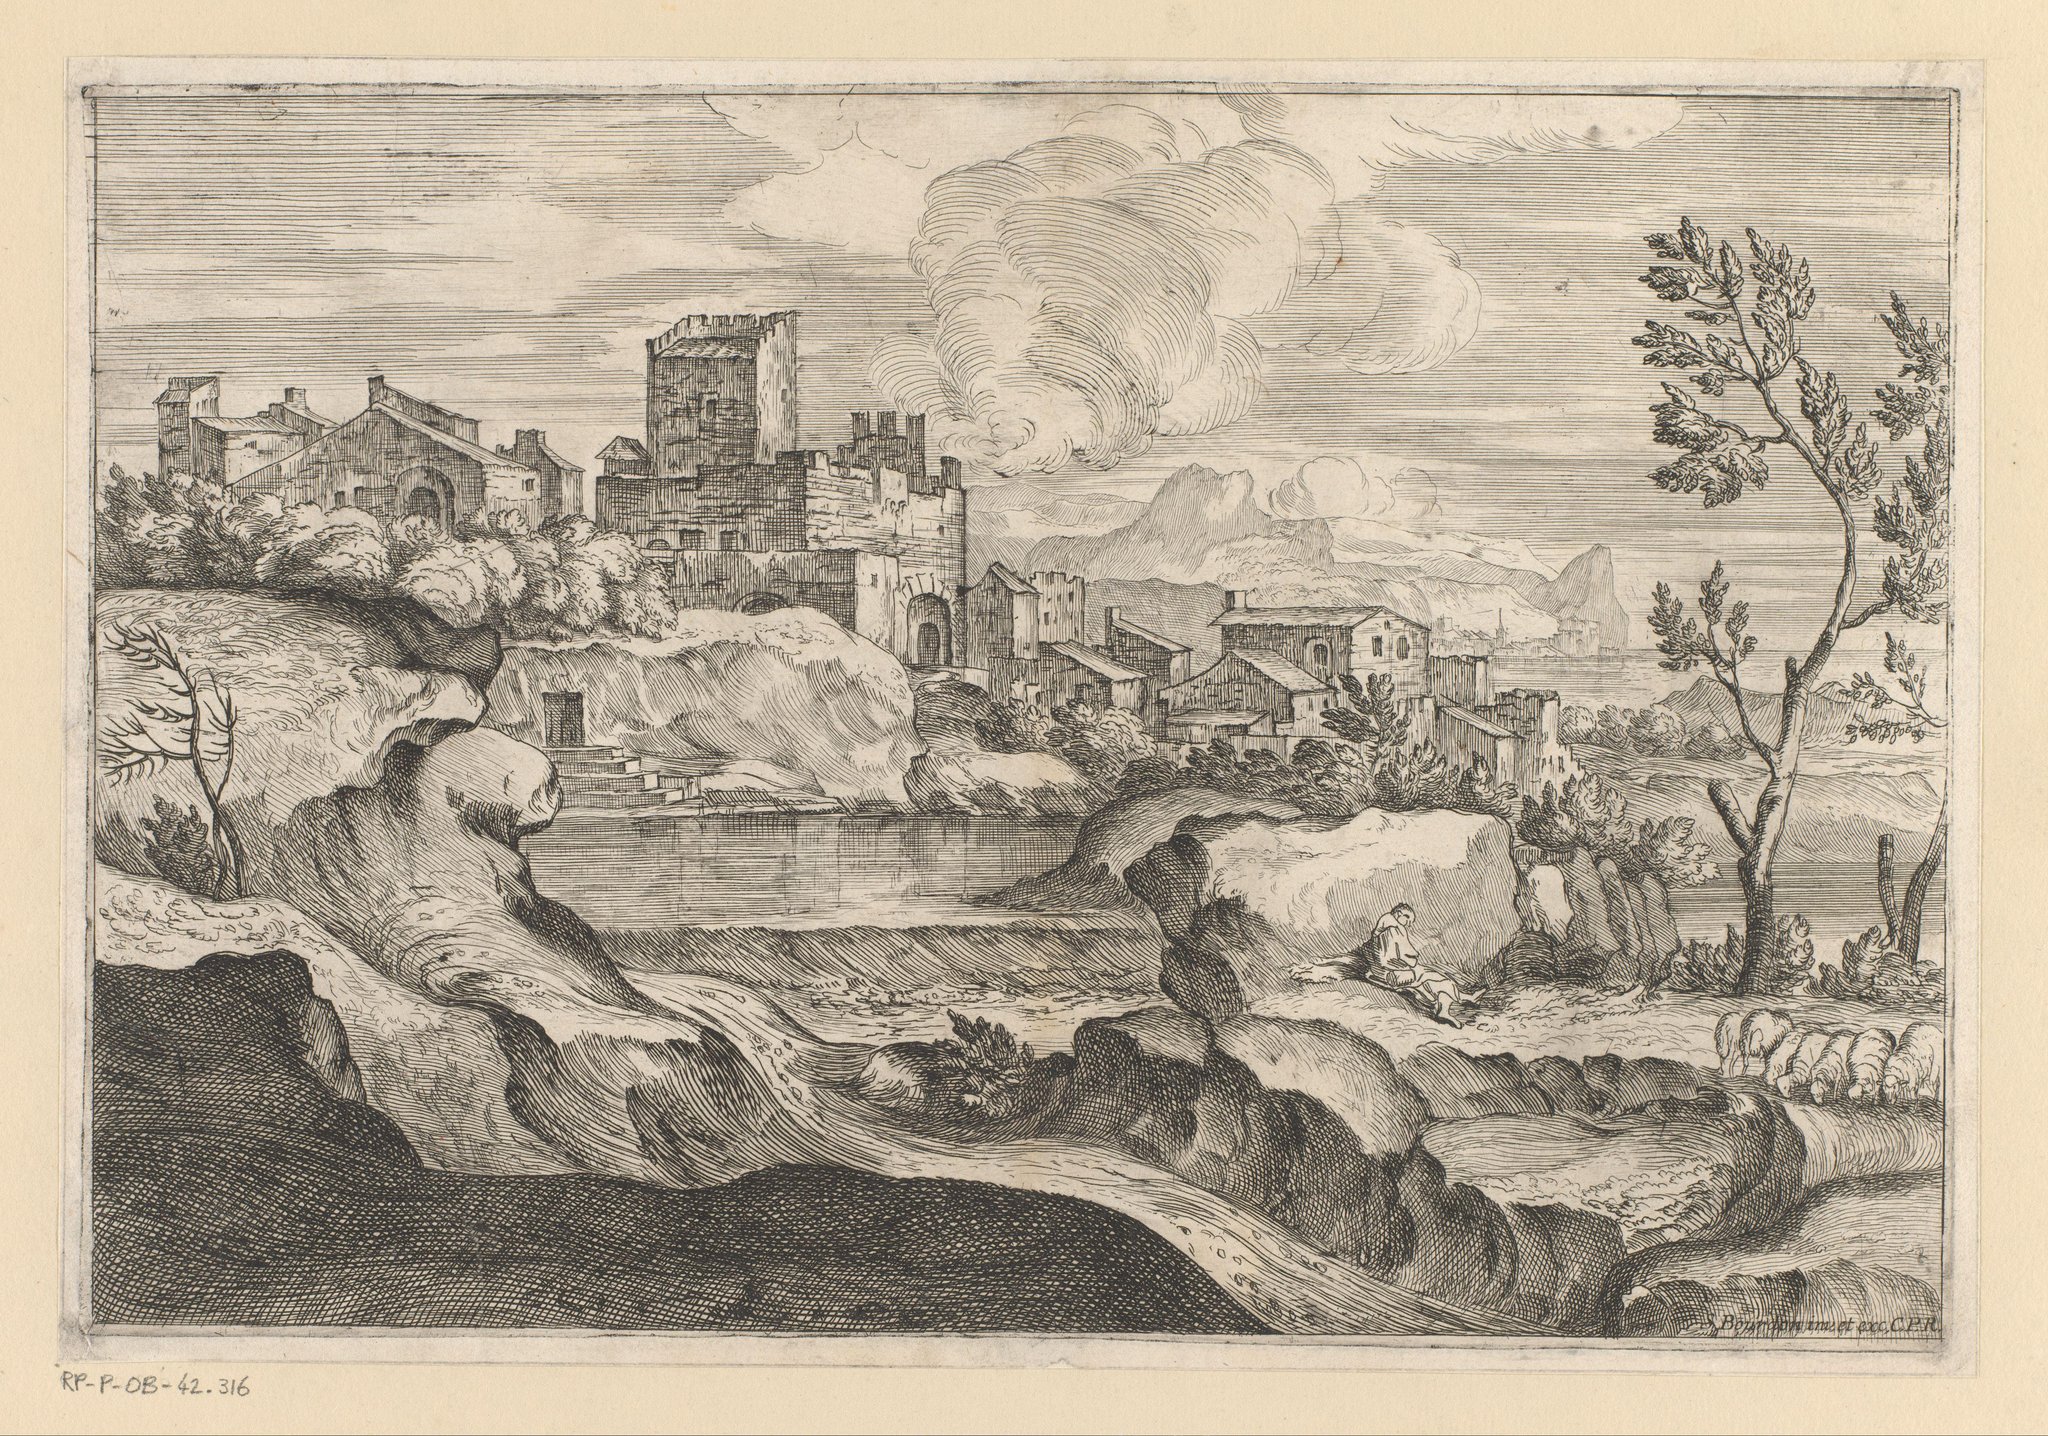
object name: print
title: Landschap met een herder met kudde voor een stad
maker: sébastien bourdon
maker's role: draughtsman, painter, print maker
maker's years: 1616-1671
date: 1626-1671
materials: paper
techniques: etching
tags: landscapes, city-view in general; 'veduta', herding, herdsman, herdswoman, shepherd, shepherdess, cowherd, etc.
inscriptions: collector's mark: Lugt 240